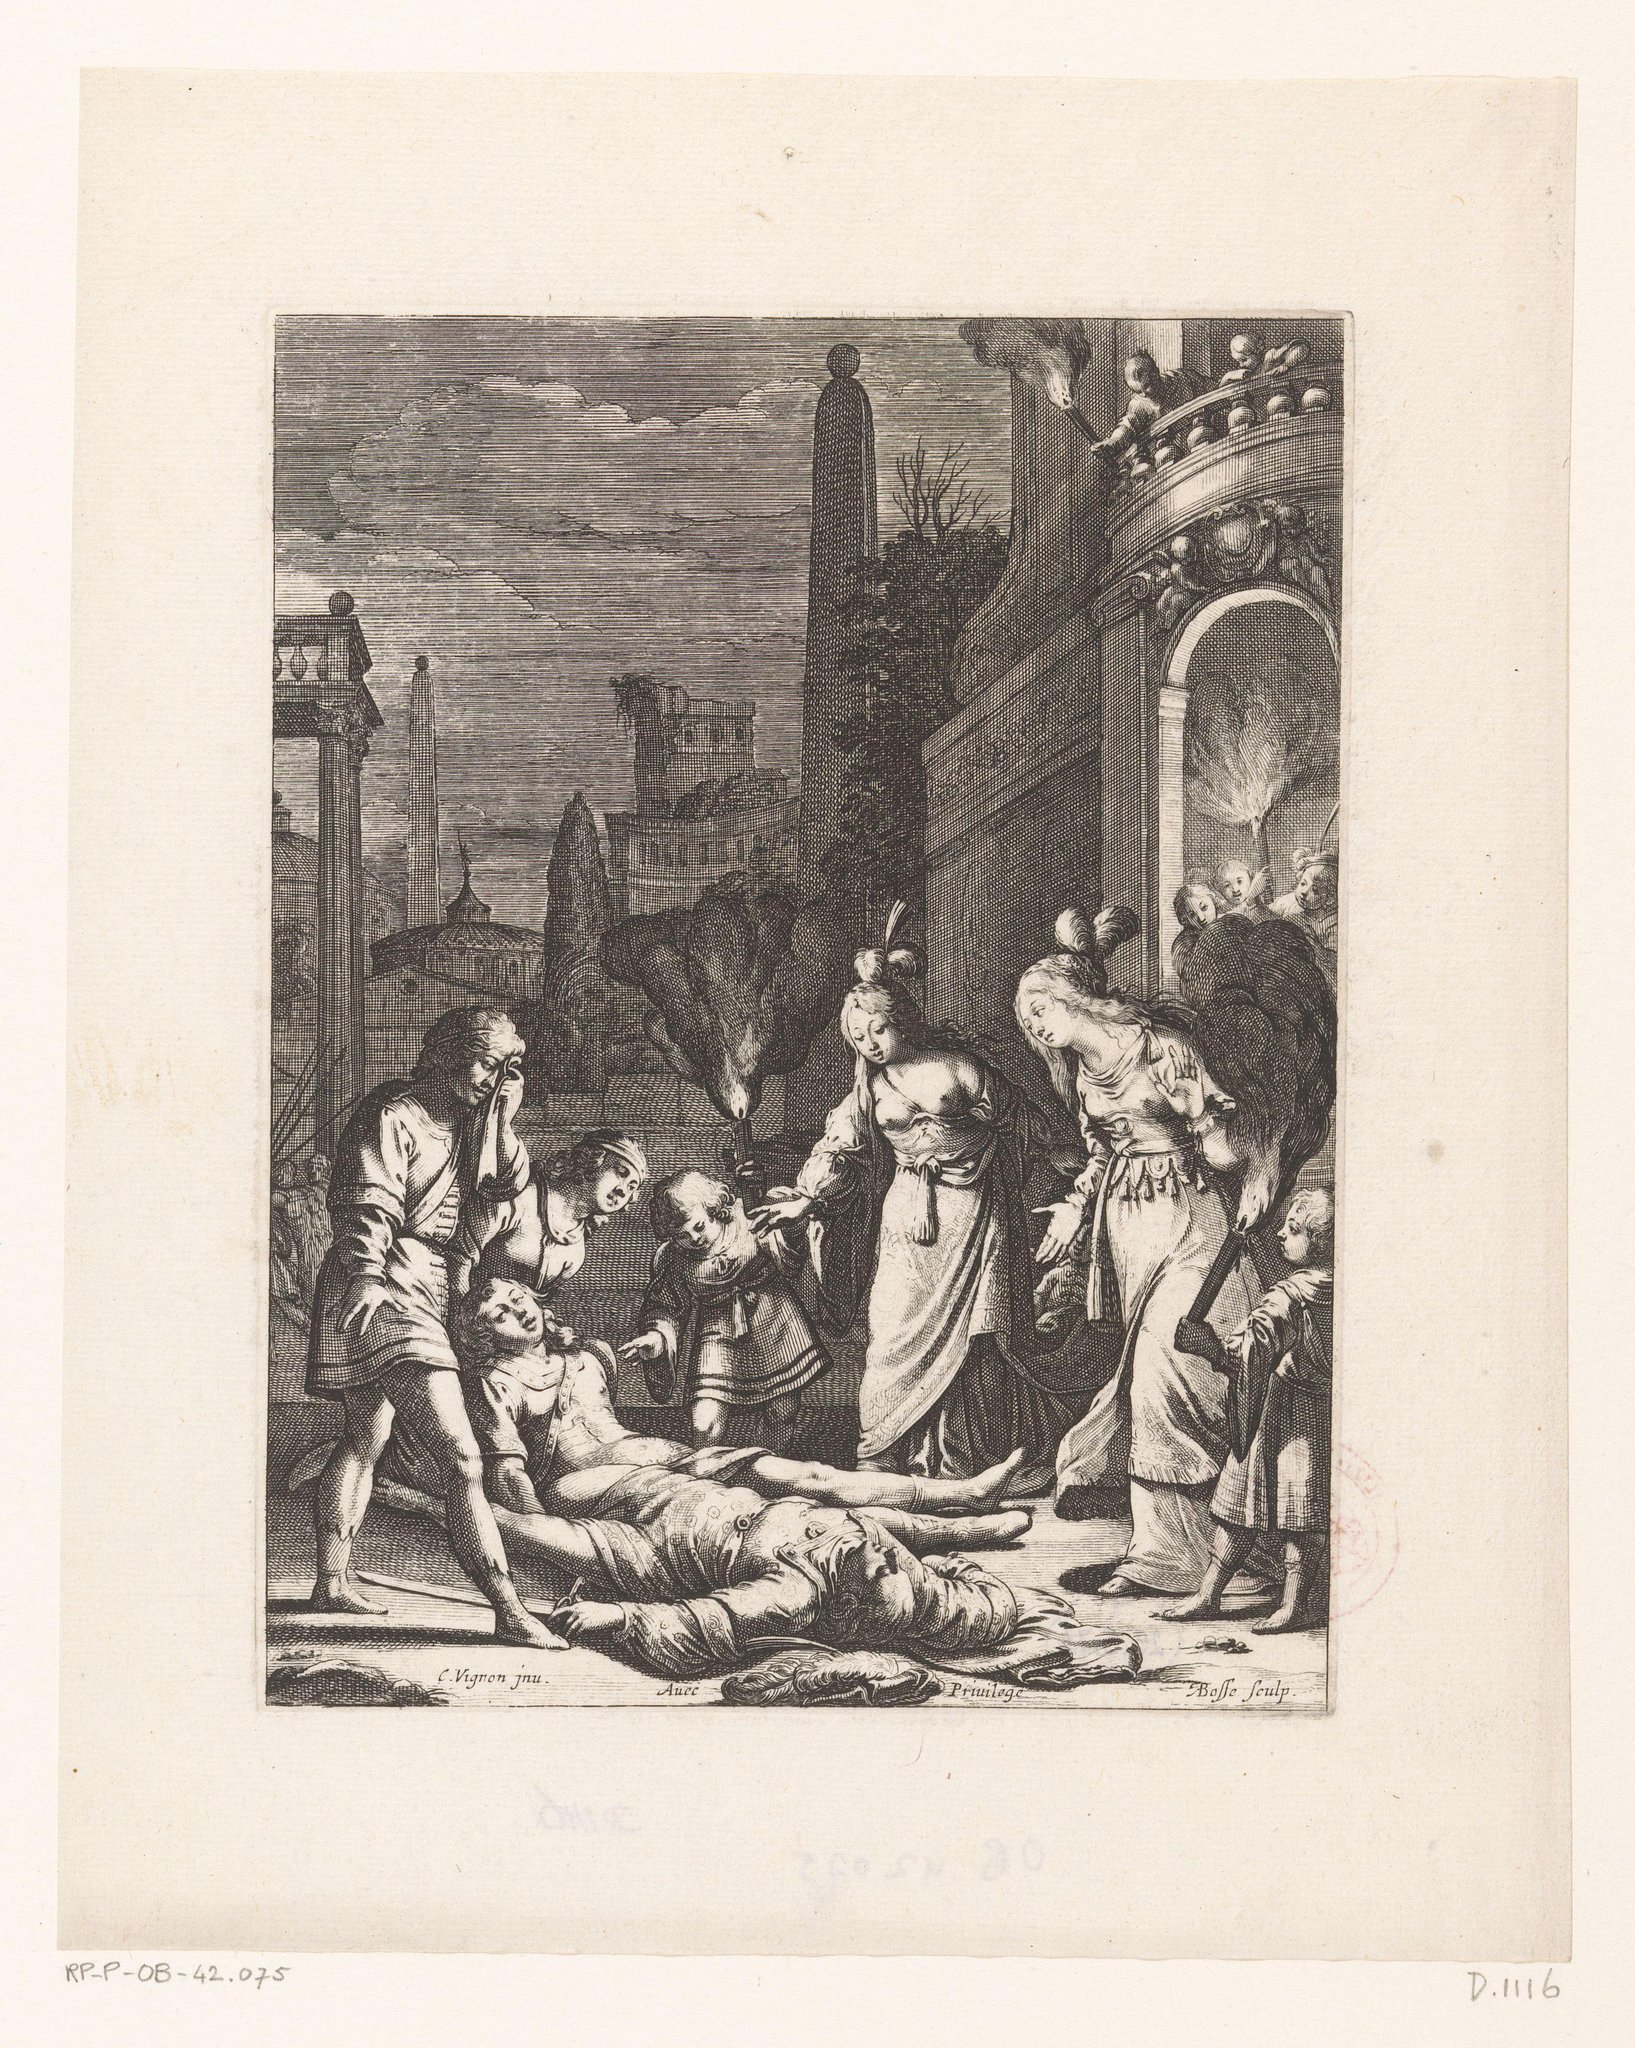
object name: print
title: Emilie en Camille vinden de gewonde Melinte en Palamède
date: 1639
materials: paper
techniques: engraving, etching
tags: nursing, tending the sick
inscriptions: collector's mark: Lugt 240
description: Prent uit: Desmarets de Saint-Sorlin, Jean. L'Ariane. Parijs: Guillemot, Matthieu, 1639.